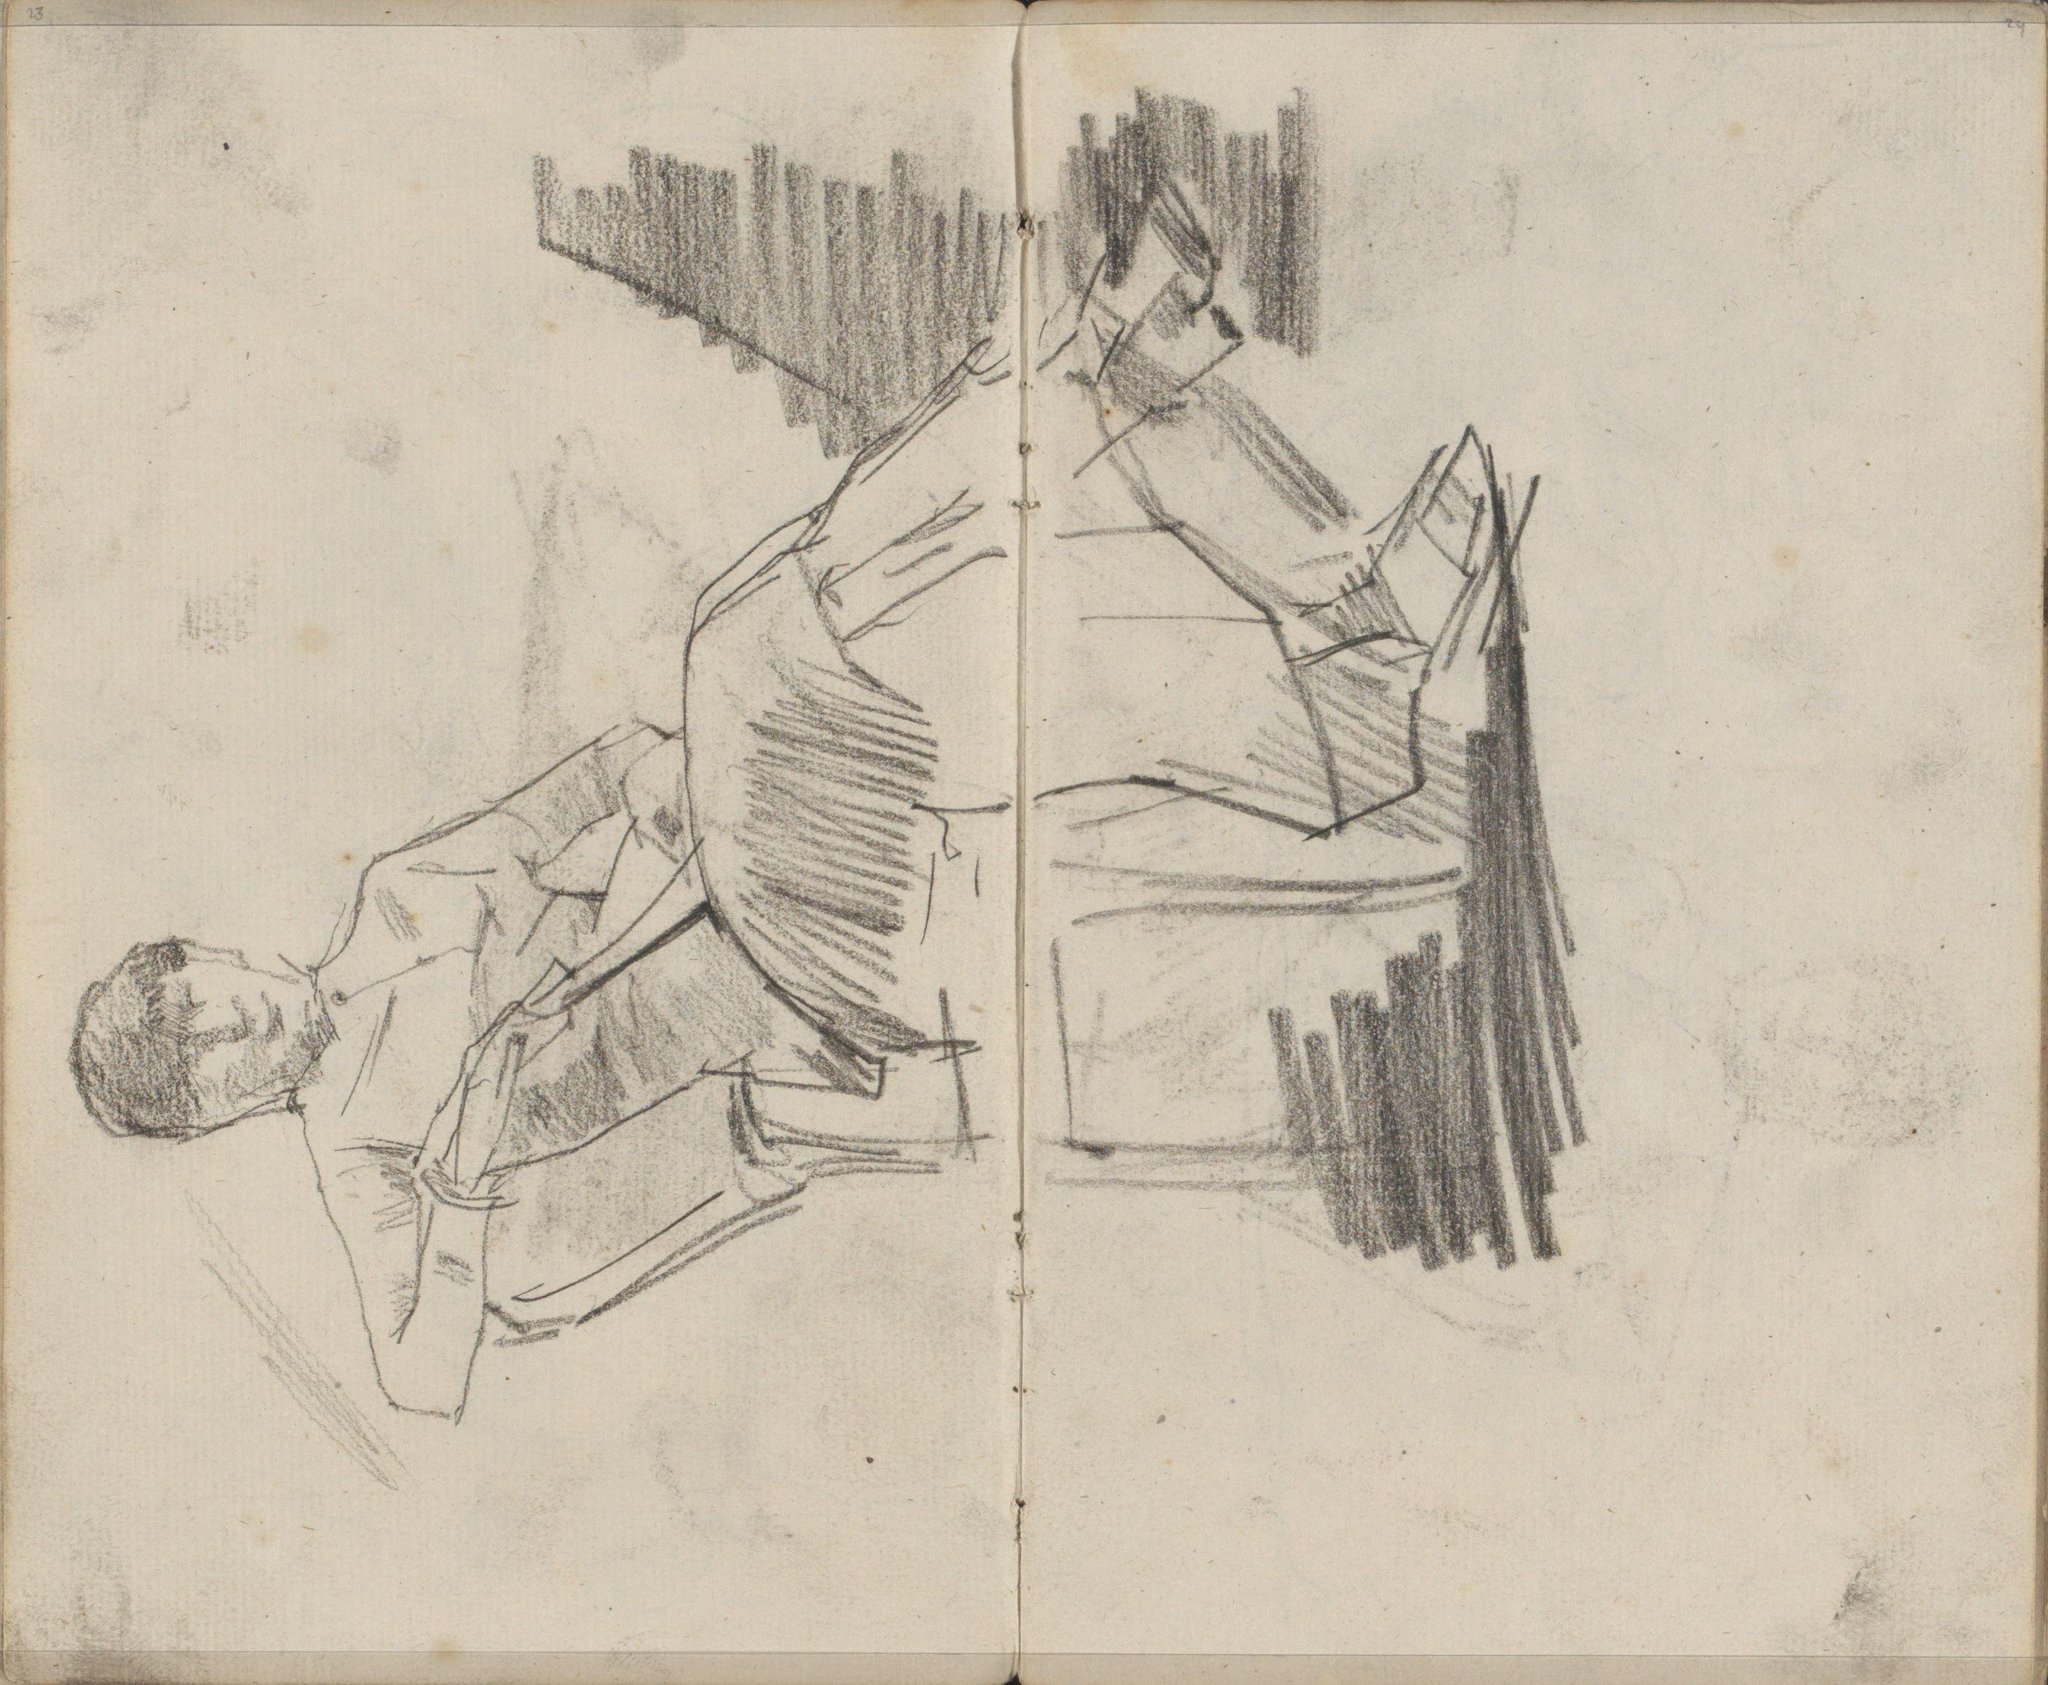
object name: sketchbook leaf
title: Vrouw op een stoel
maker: george hendrik breitner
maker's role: draughtsman, painter, print maker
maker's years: 1857-1923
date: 1881-1883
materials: paper, pencil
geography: rotterdam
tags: chair, sitting on an elevation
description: Pagina 23 en pagina 24 uit een schetsboek met 27 bladen